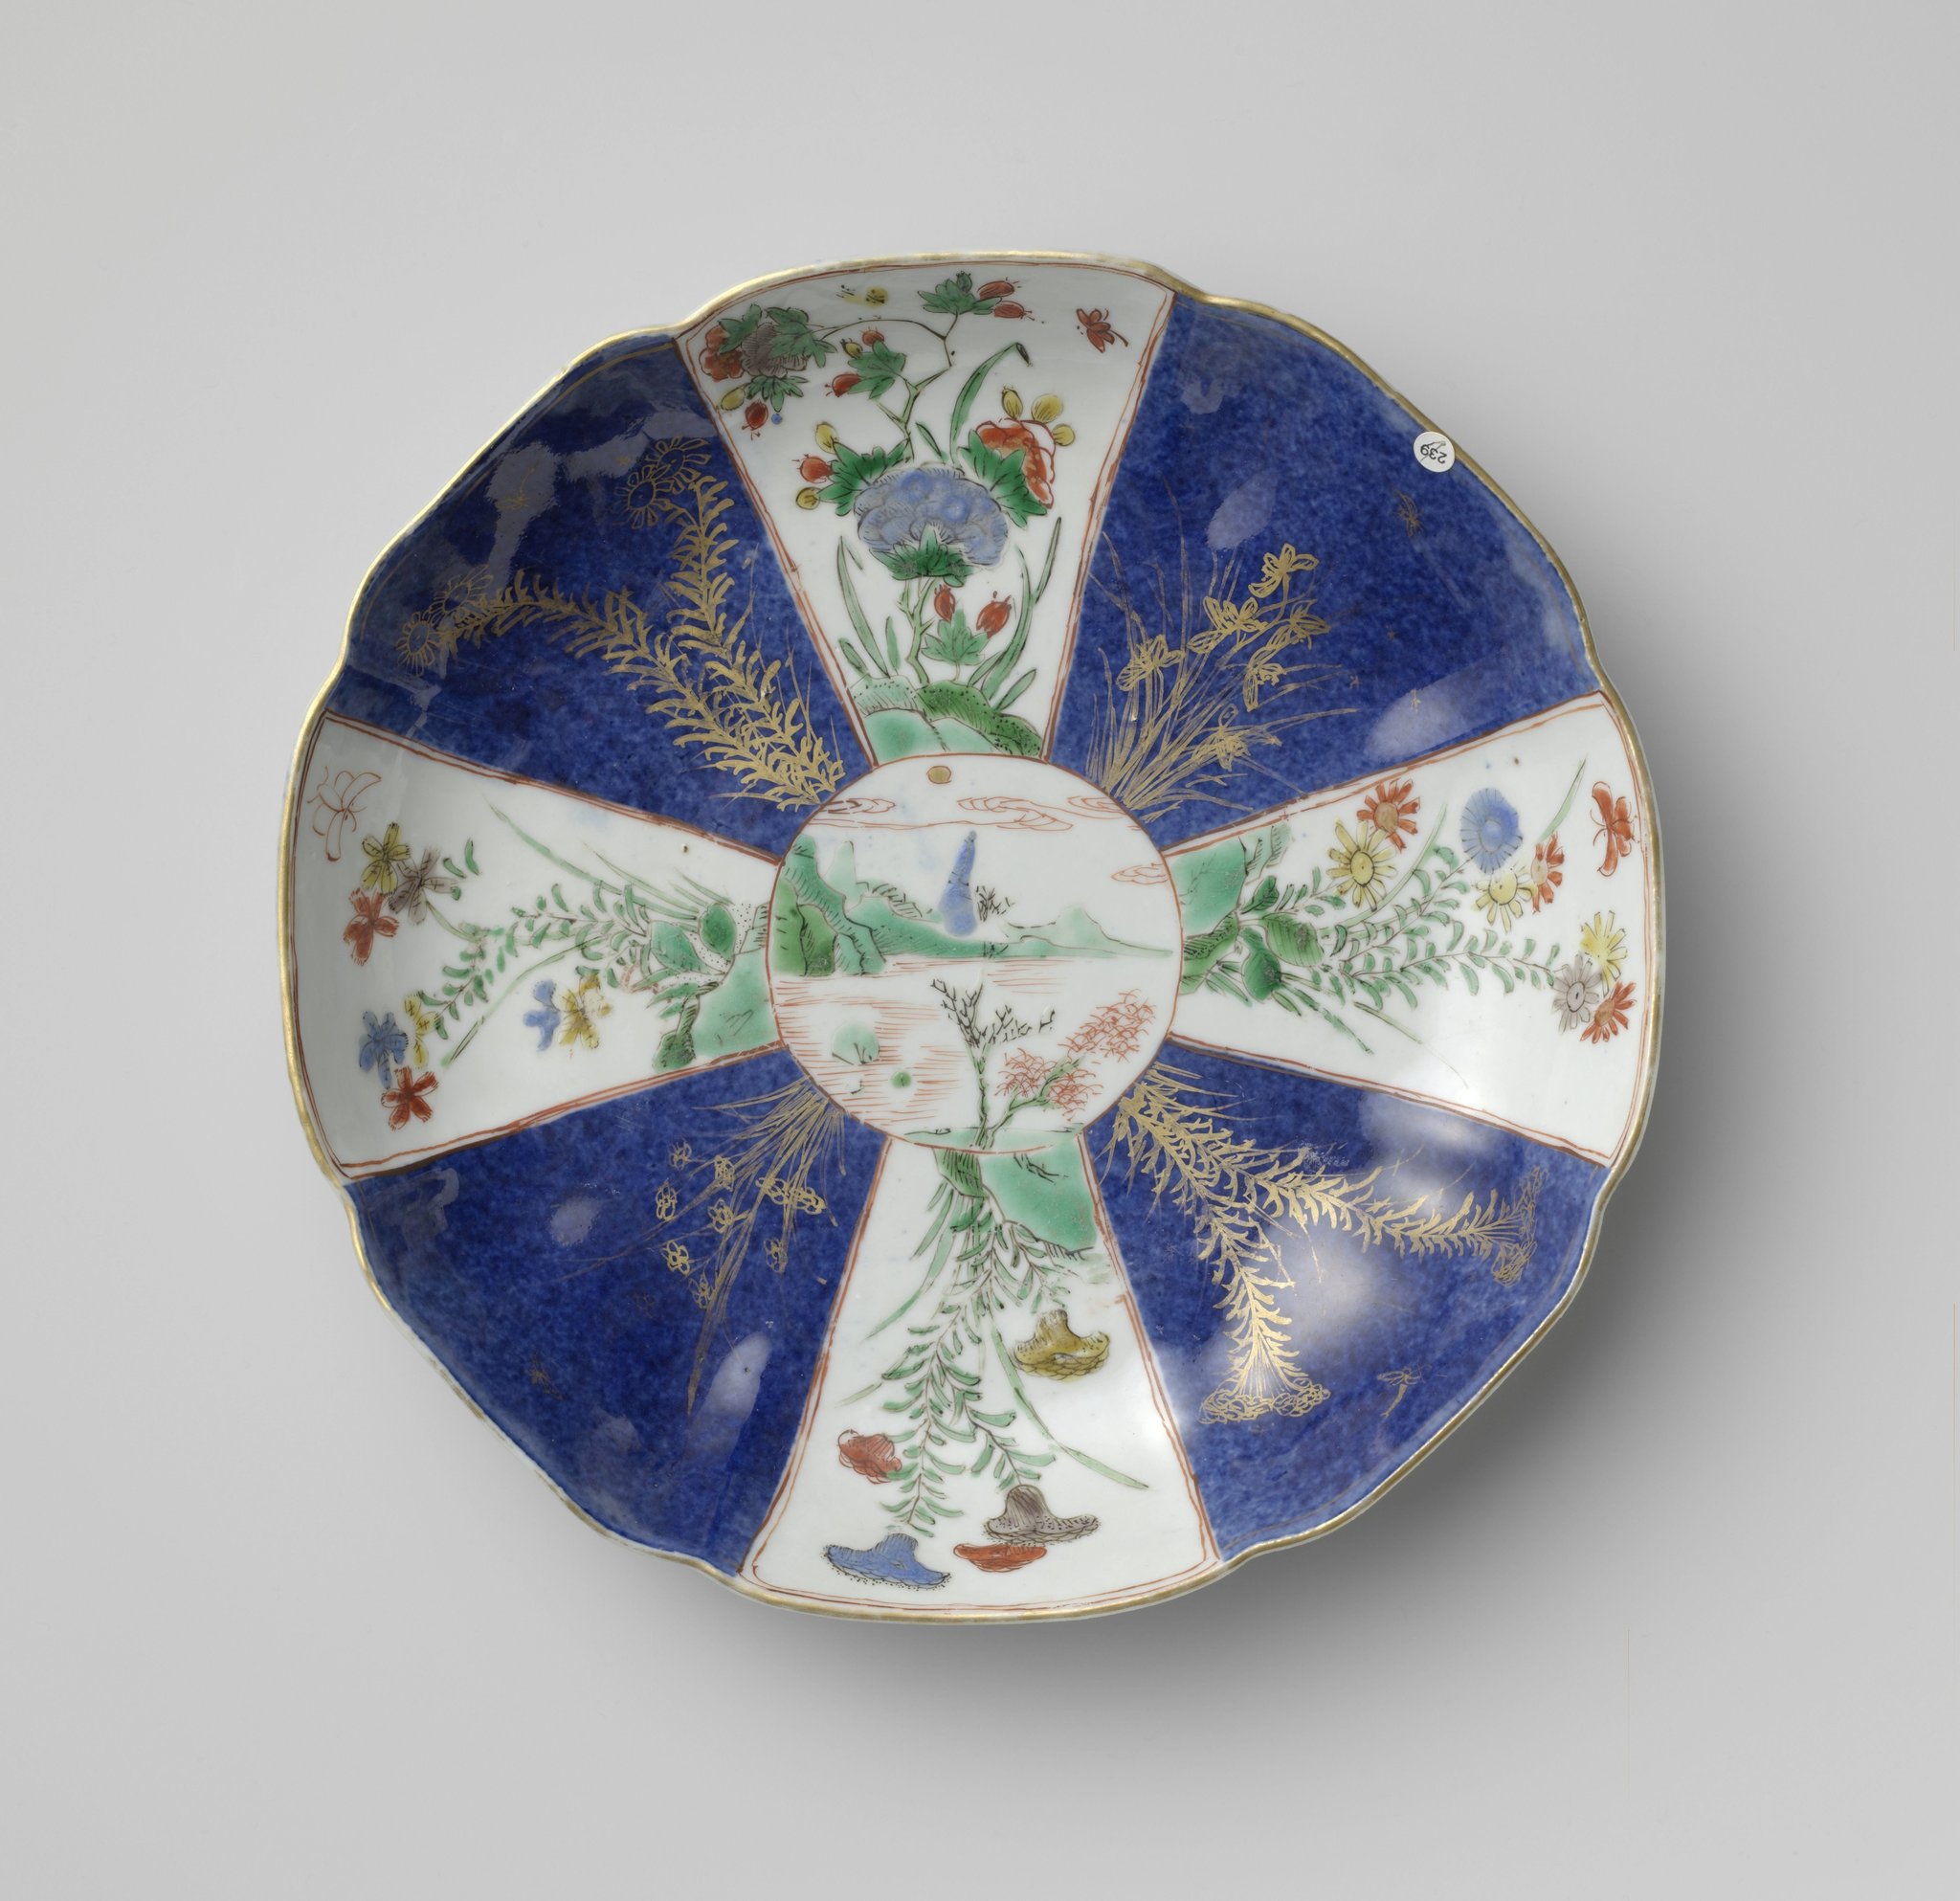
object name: plate dish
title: Saucer-dish in the shape of a flower with bleu poudré and panel decoration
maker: Anonymous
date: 1700-1724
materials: cobalt, glaze, gold, paint, porcelain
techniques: firing, gilding, turning, vitrification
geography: china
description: Schotel van porselein met ronde, gelobde wand en geschulpte rand in de vorm van een bloem, beschilderd in onderglazuur blauw en op het glazuur blauw, rood, groen, geel, aubergine, zwart en goud met een vakdecoratie. Op het plat een medaillon met rivierlandschap met paviljoen, rotsen en bomen; de wand is gemodelleerd in acht bloembladeren afwisselend gevuld met een bloemtak en vlinder in goud op een bleu poudré (poederblauw) grond en een bloemtak op een rots met vlinder op een witte grond. Bleu poudré met famille verte.